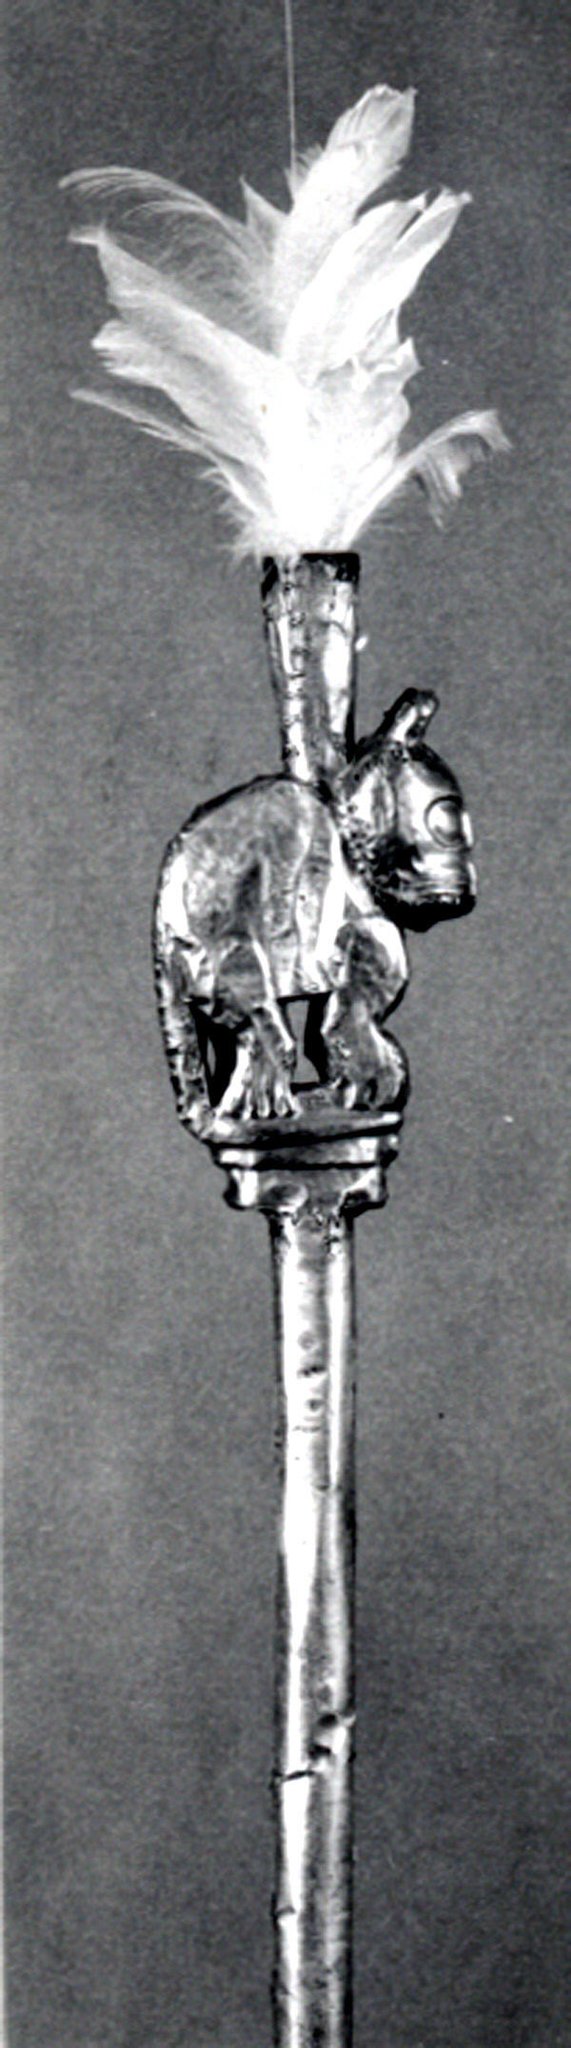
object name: tomb post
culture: inca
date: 1401-1600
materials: feather, silver, wood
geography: peru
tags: animals